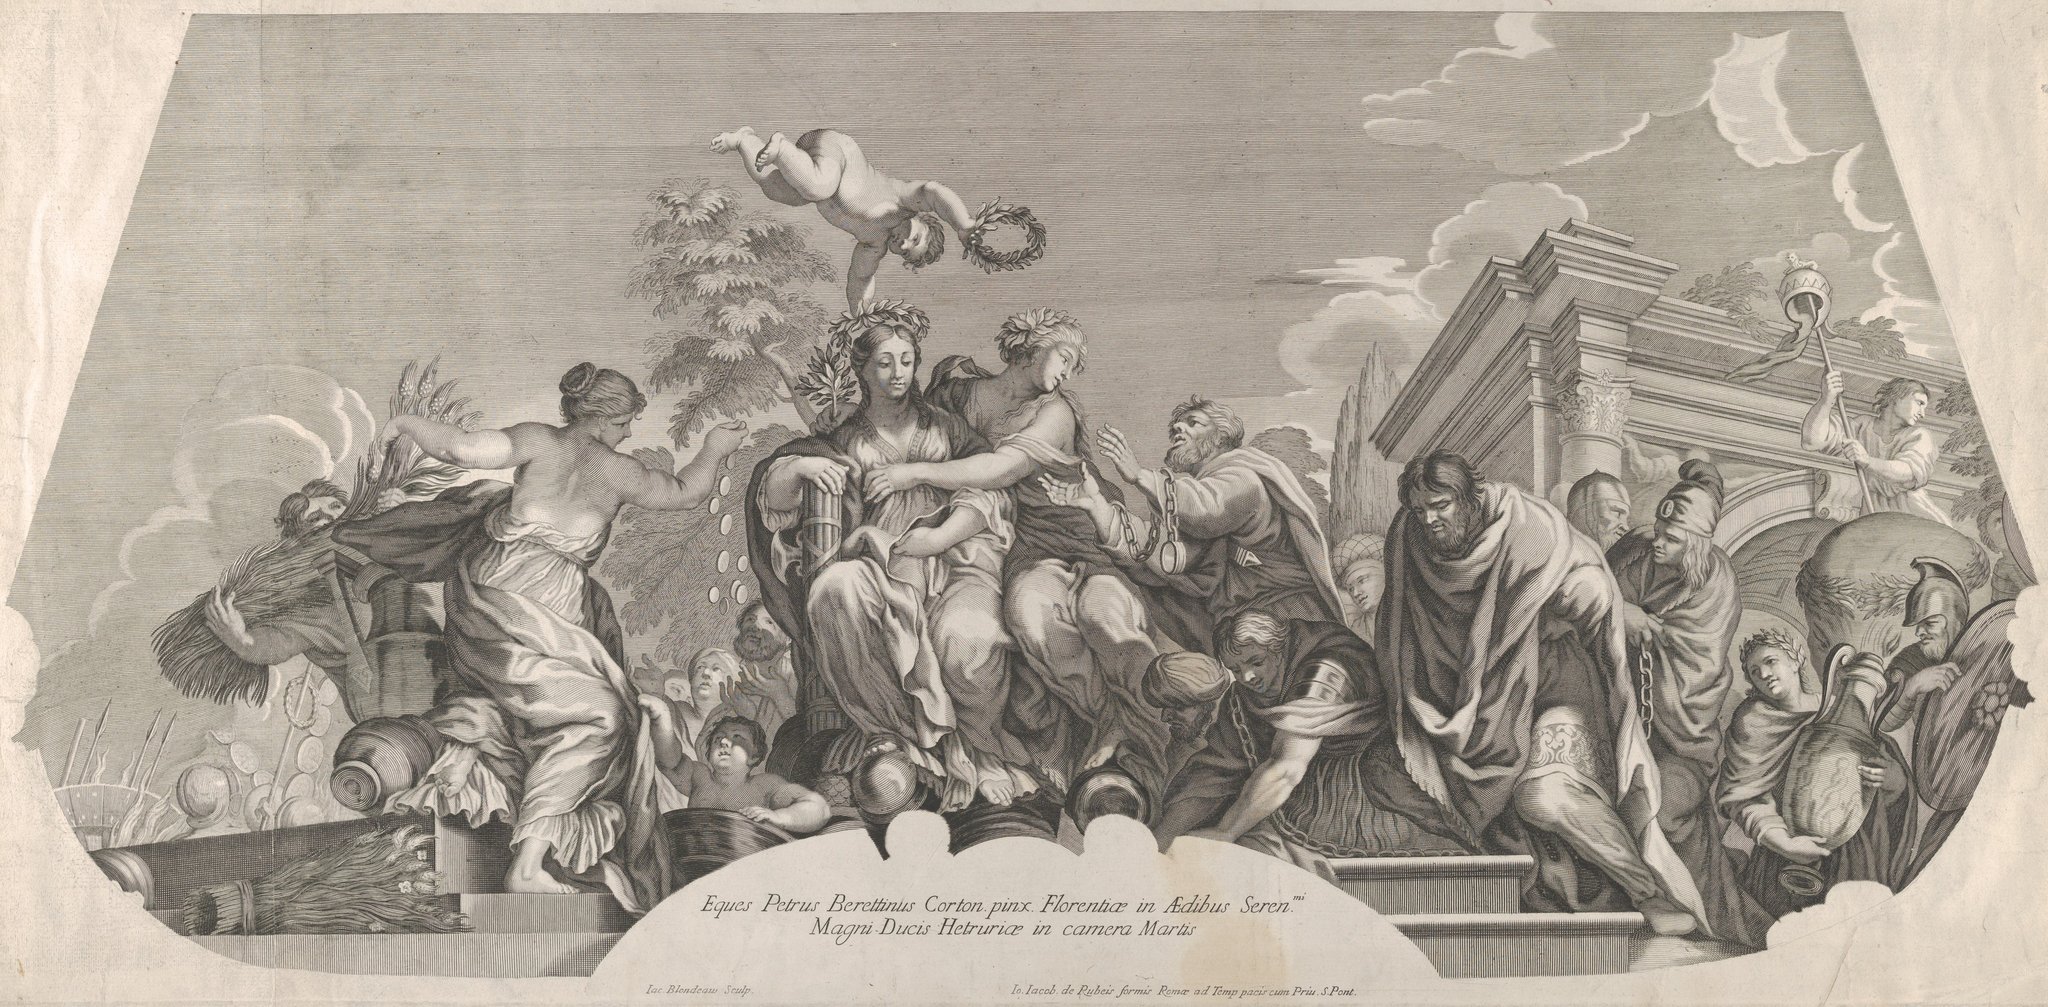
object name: print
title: An allegorical composition with Charity and prisoners in chains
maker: jacques blondeau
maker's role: artist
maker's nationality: flemish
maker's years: 1655-1698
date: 1677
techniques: engraving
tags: men,women